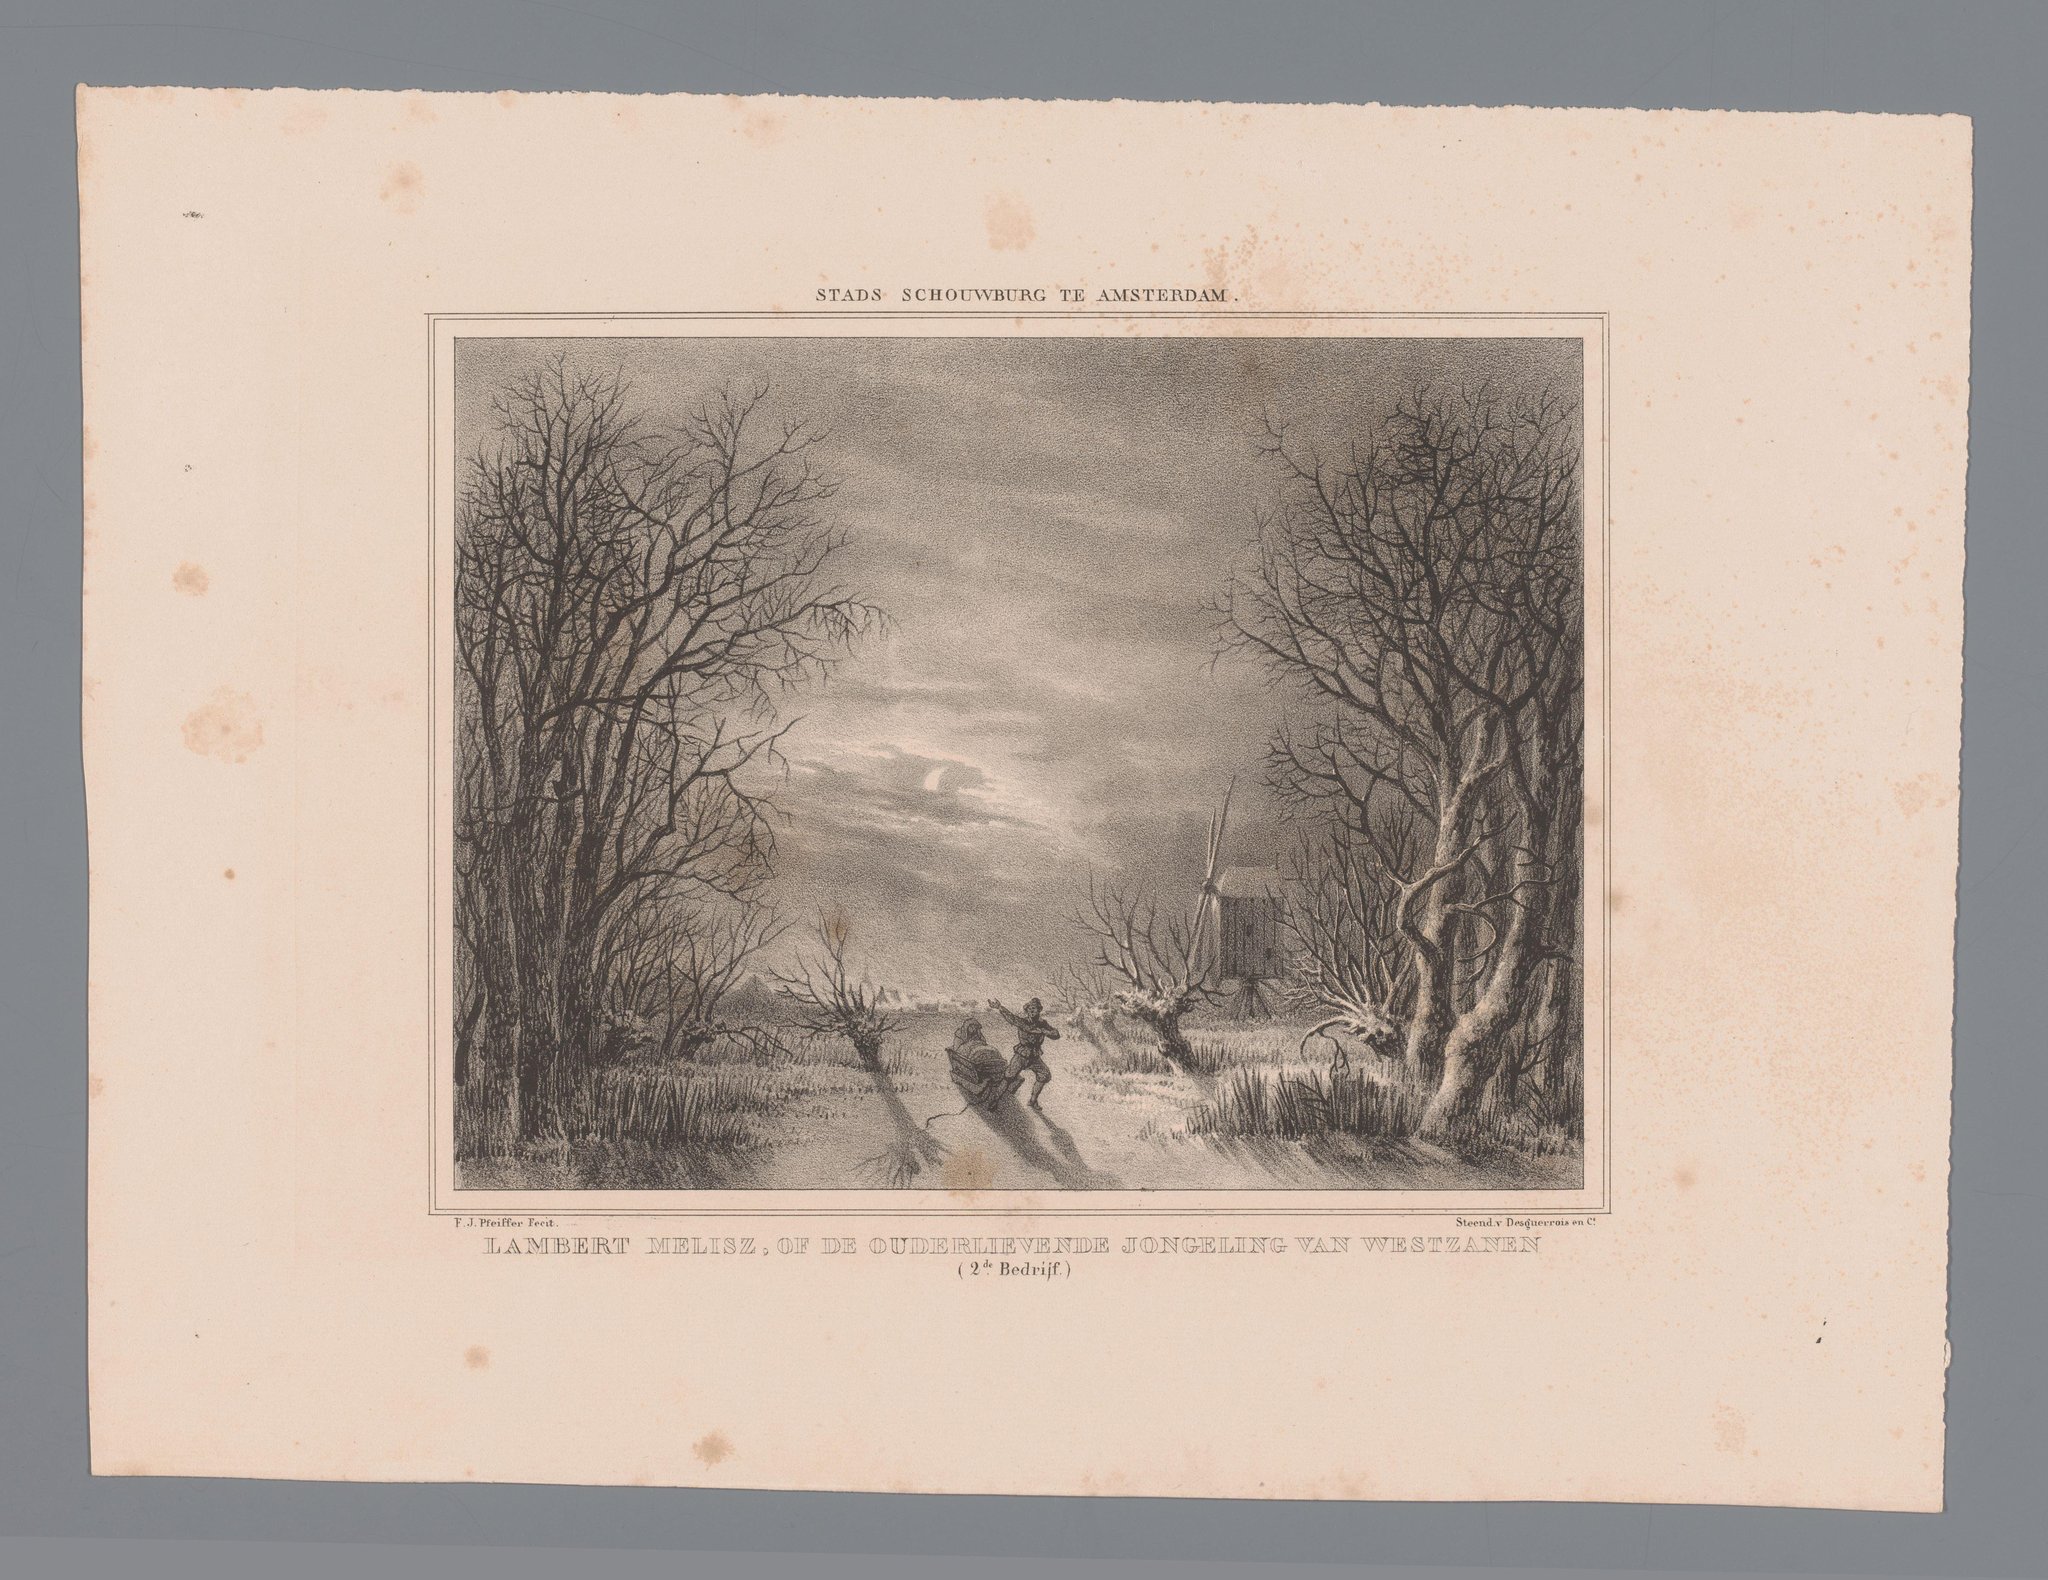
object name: print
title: Tooneel Decoratief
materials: paper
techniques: lithograph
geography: amsterdam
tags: mother and son(s) (family group), group of actors, troupe; actors on the stage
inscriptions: collector's mark: Lugt 2228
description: Lambert Melisz trekt zijn moeder zittend op een slee voort over een bevroren plas. In de achtergrond brandt het door de Spanjaarden bezette dorp Westzaan. Onderdeel van een omslag met een serie van zeven lithografieën van operascènes opgevoerd in de stadsschouwburg te Amsterdam.